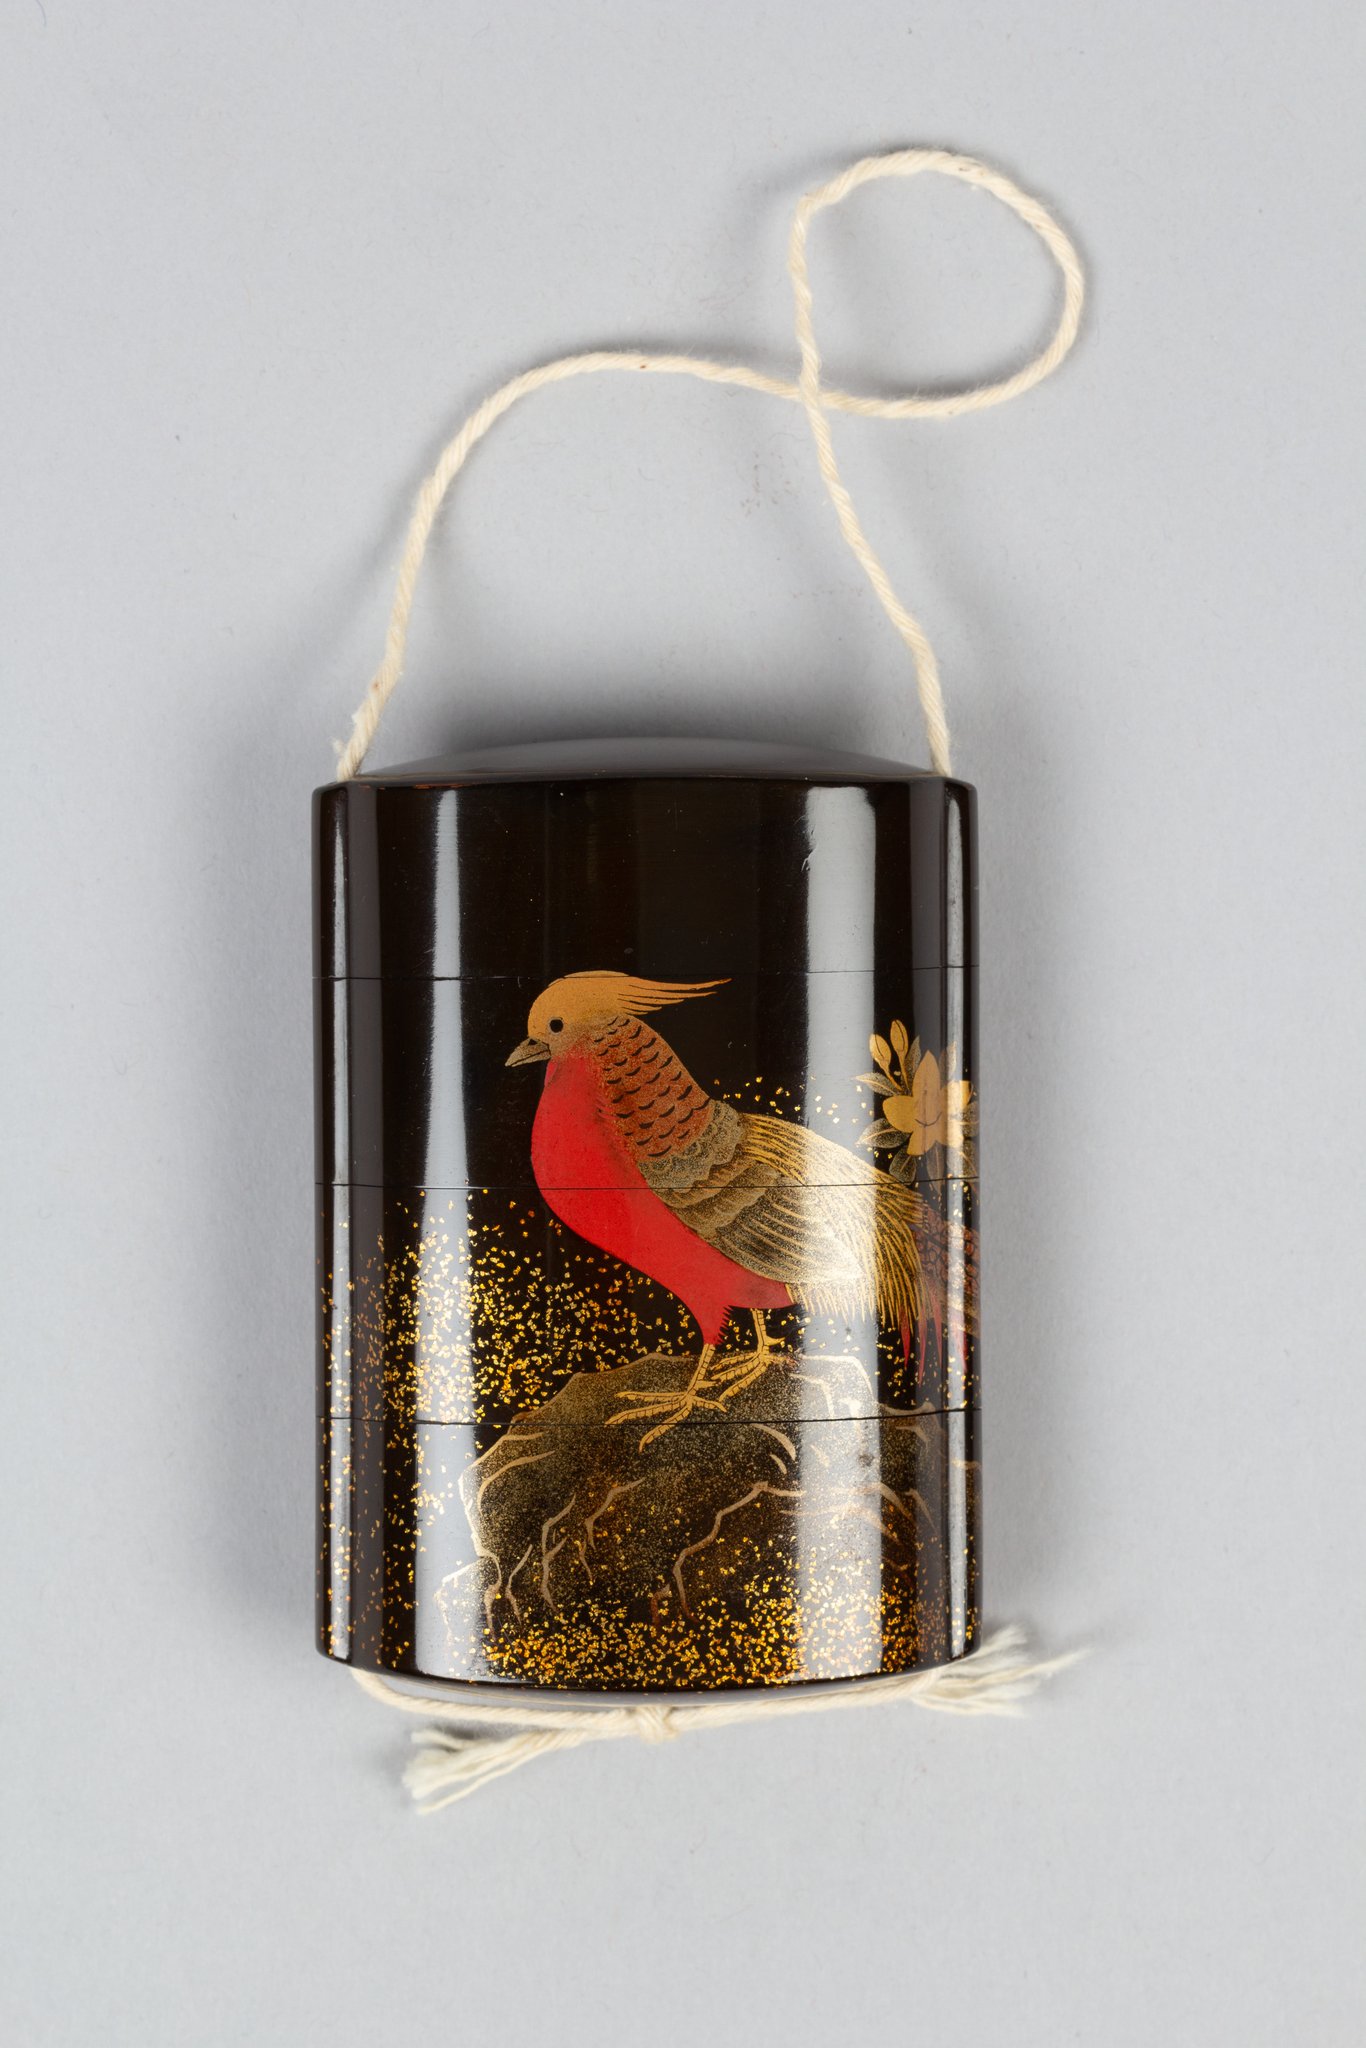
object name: inrō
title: Case (Inrō) with Design of Pheasant on Rocks beside Flowering Azalea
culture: japanese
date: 1701-1900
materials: gold, lacquer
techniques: fundame, roiro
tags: pheasants,flowers